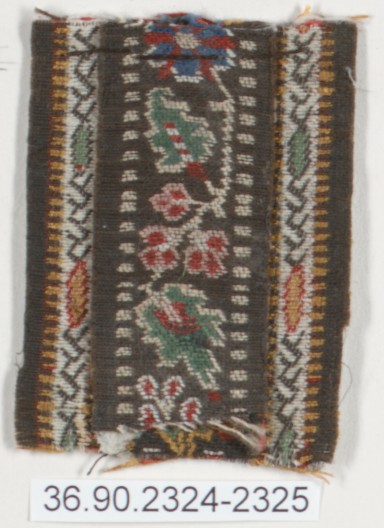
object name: border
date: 1801-1900